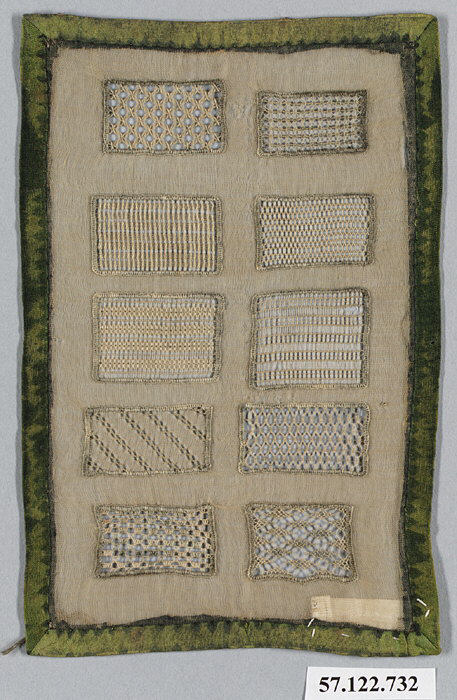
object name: sampler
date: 1801-1900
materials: linen, silk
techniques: embroidery